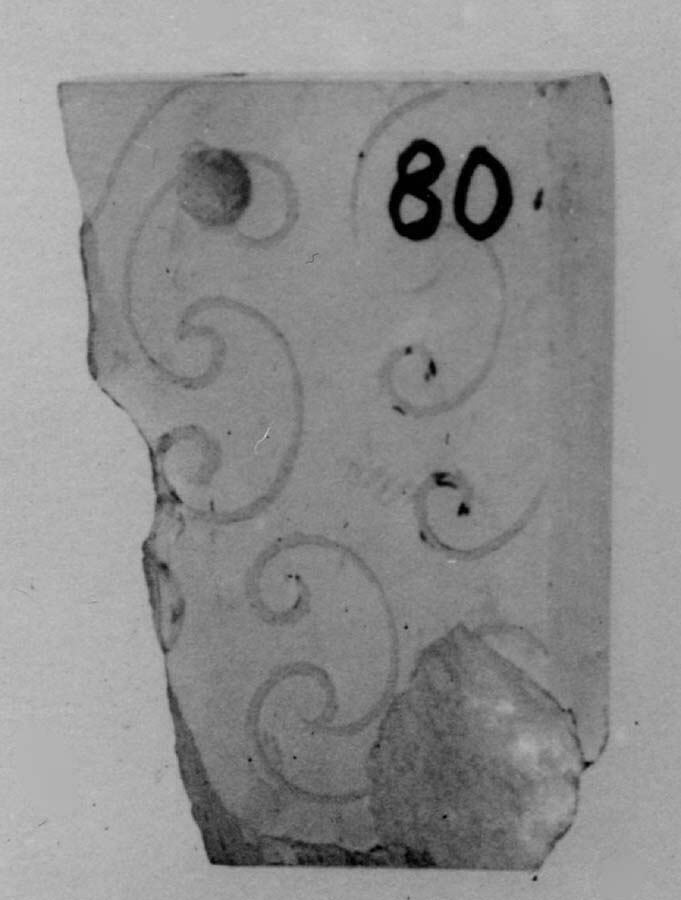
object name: fragment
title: Fragment of a Medallion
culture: chinese or turkestani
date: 1902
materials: jade